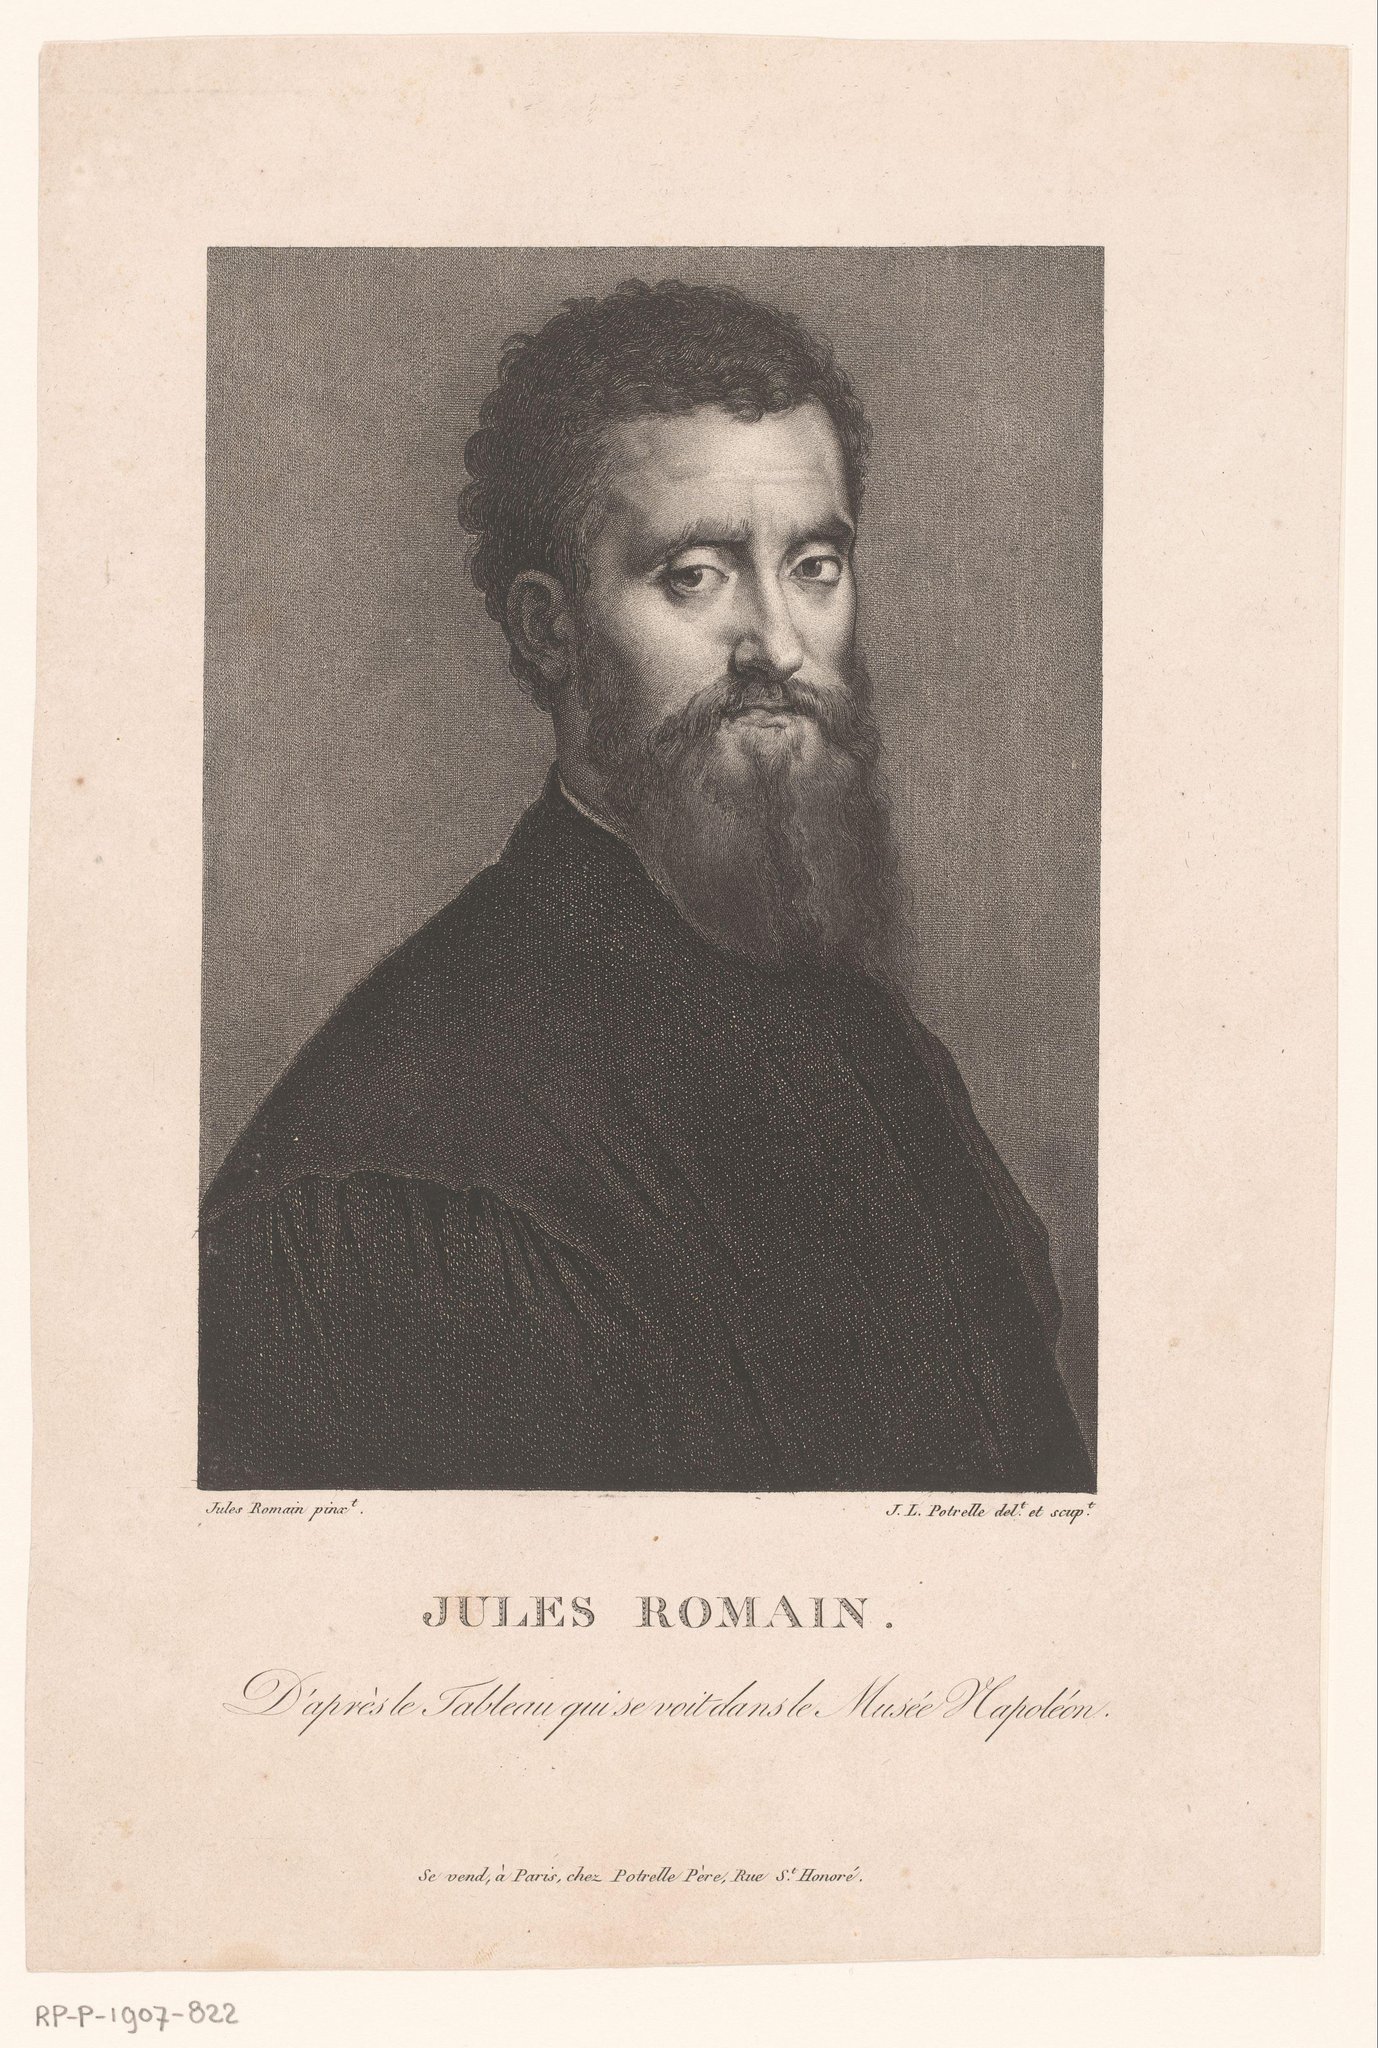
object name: print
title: Portret van Giulio Romano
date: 1798-1898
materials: paper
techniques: engraving, etching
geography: paris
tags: painter, print maker, giulio romano, historical persons, portrait, self-portrait of painter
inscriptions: collector's mark: Lugt 2228